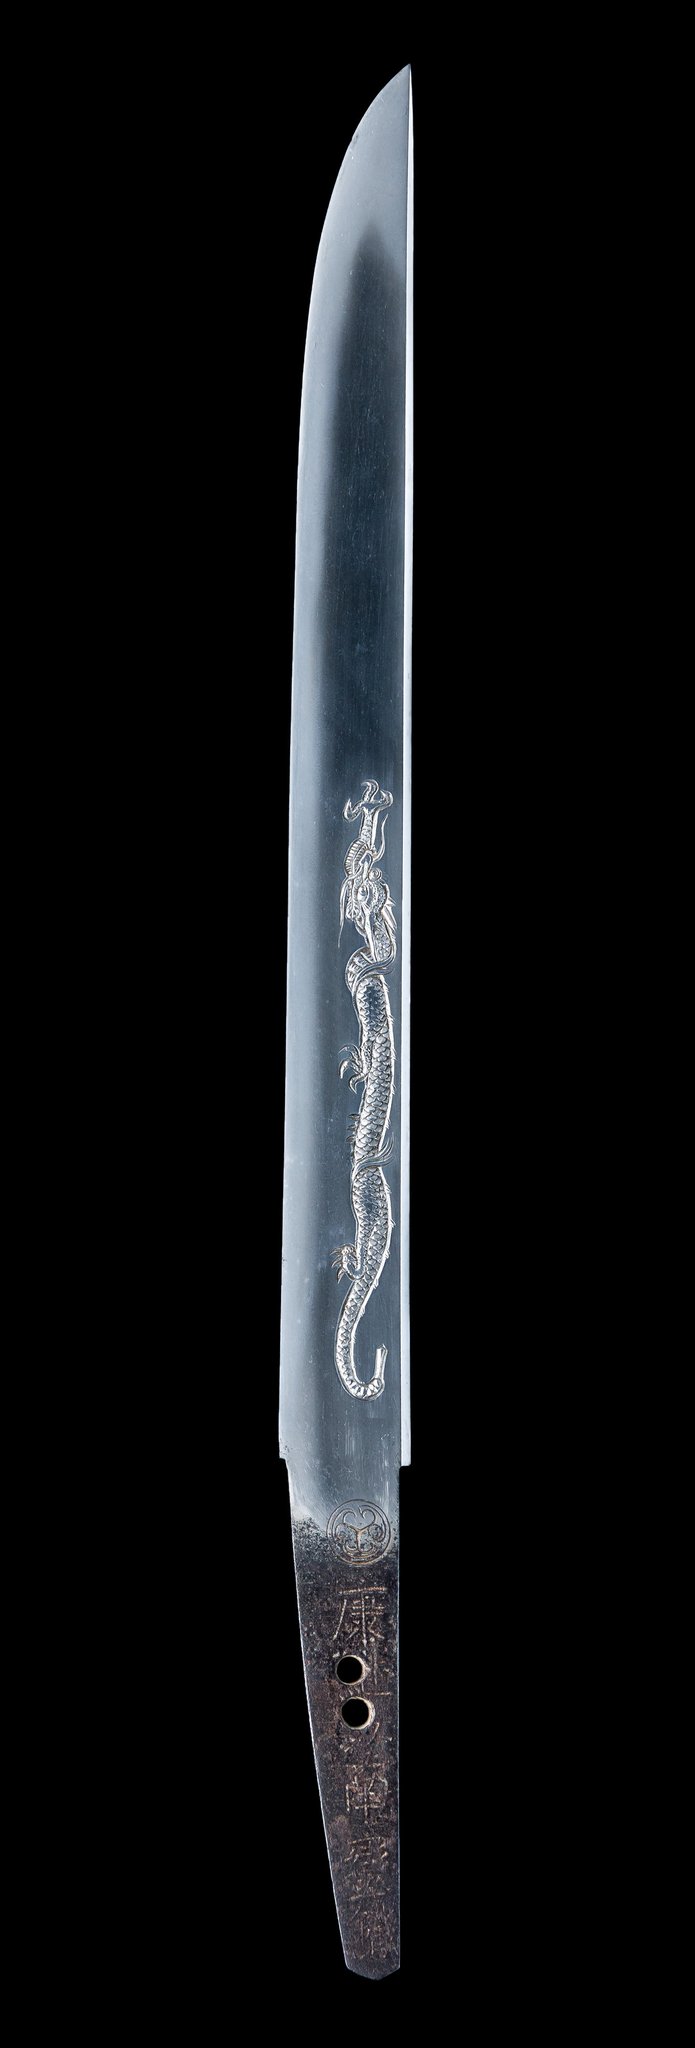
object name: blade and mounting for a dagger tantō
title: Blade and Mounting for a Dagger (Tantō)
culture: japanese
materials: gold alloy, gold, lacquer, steel, thread, wood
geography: japan